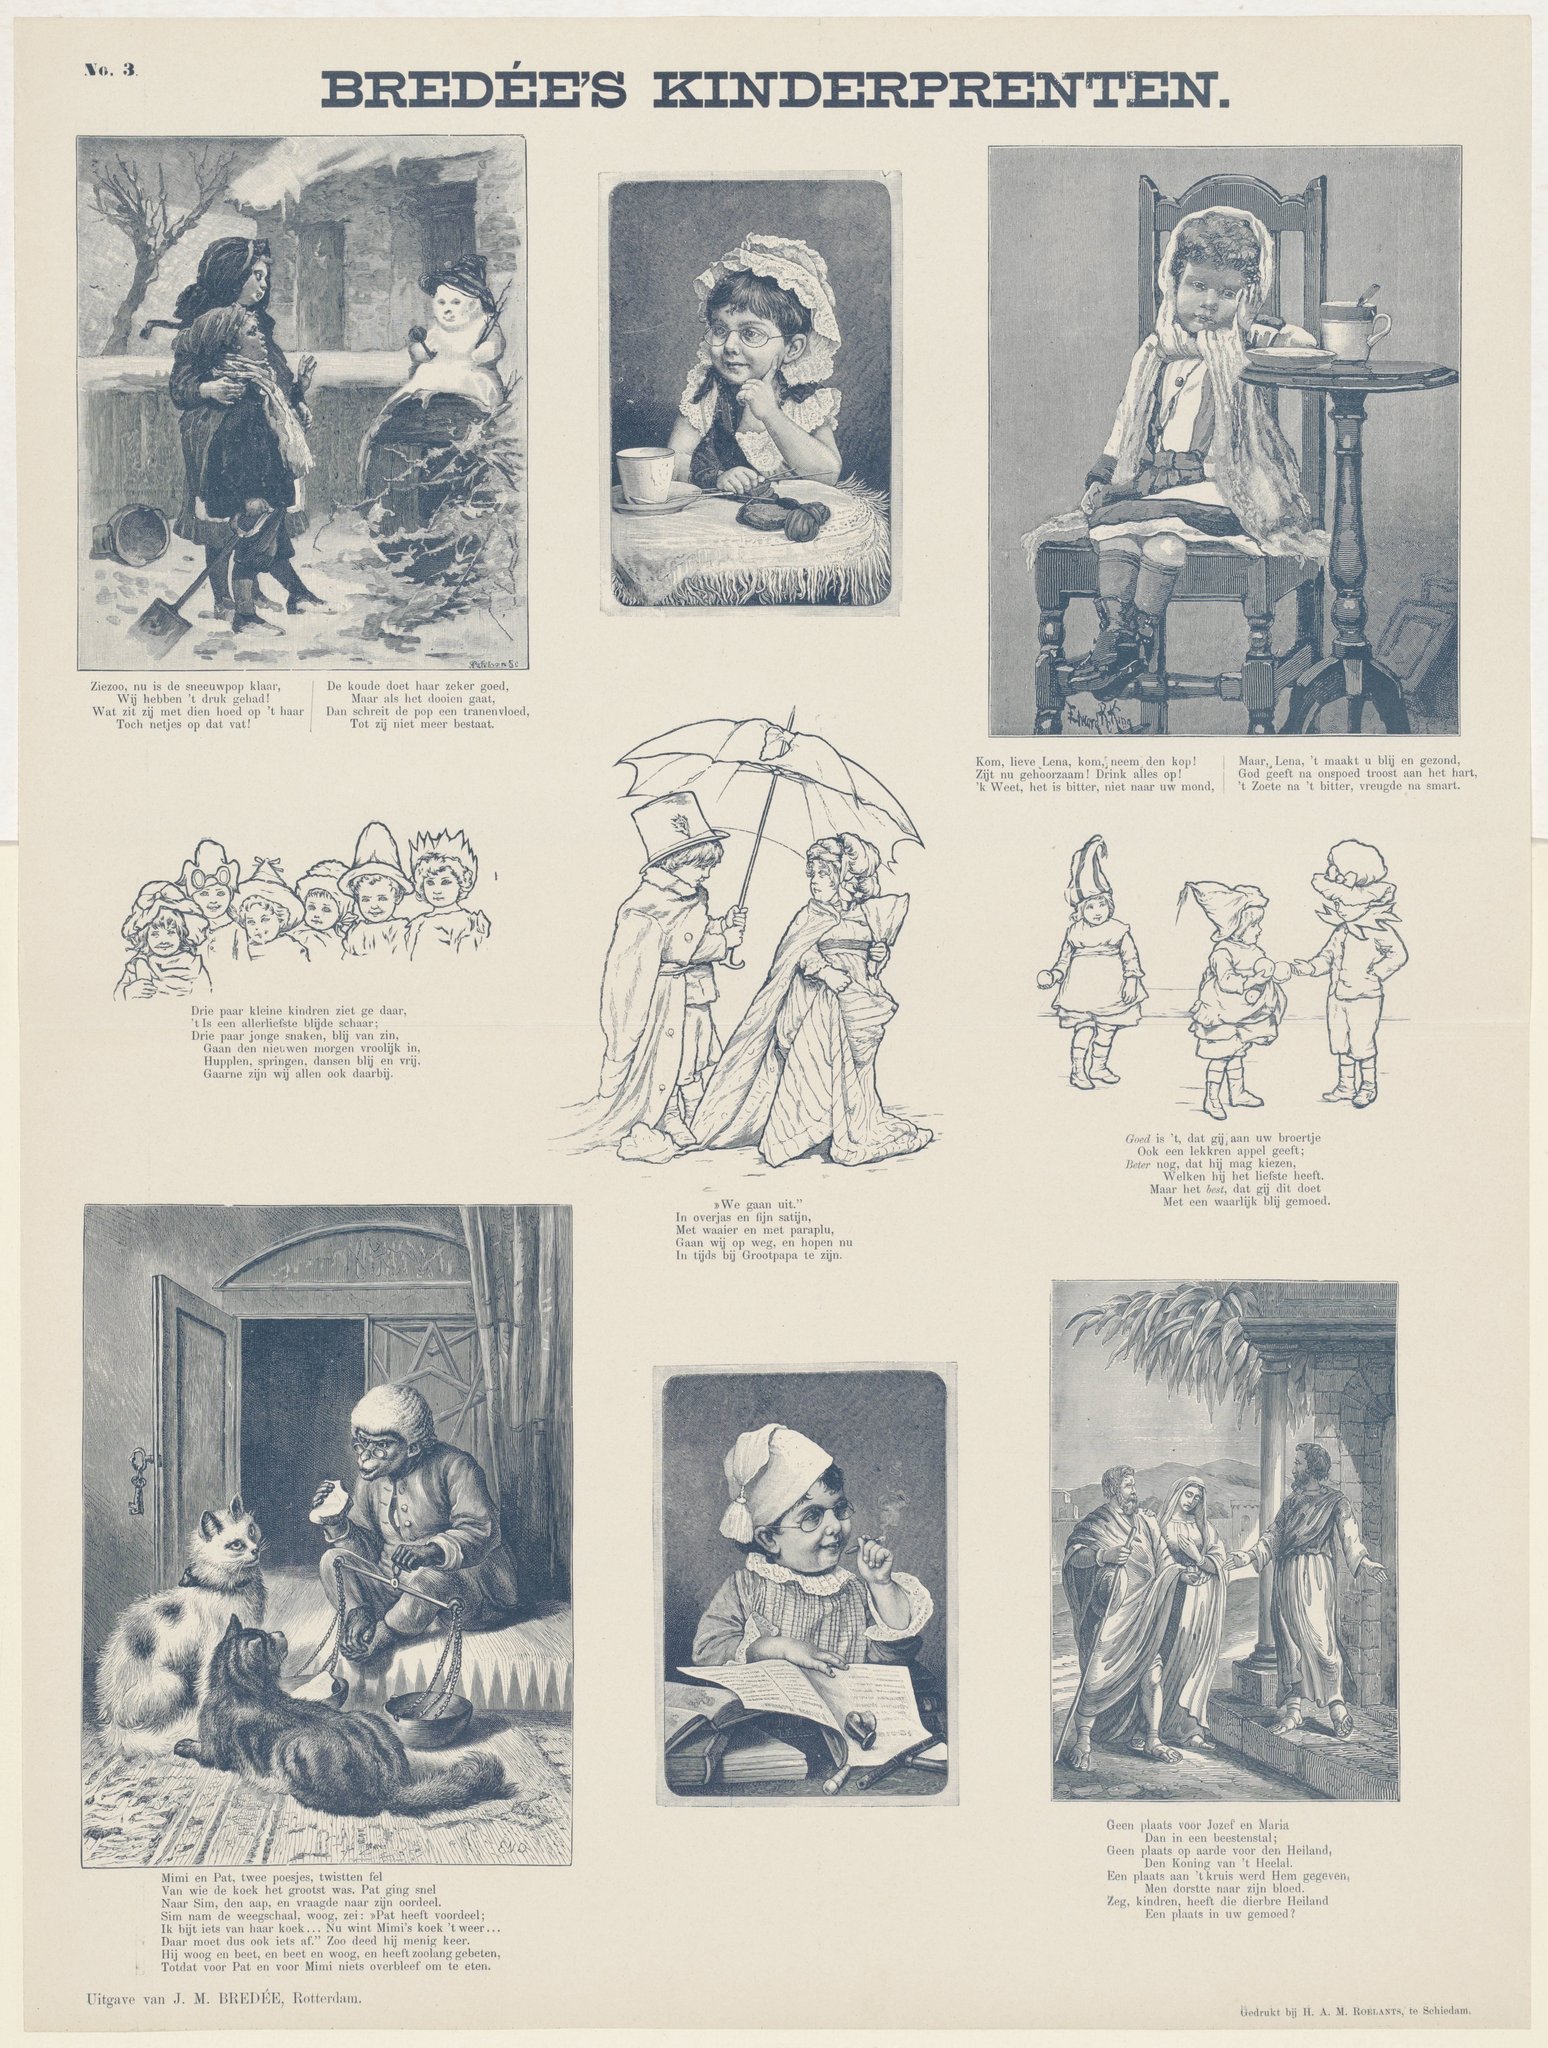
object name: print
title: Verschillende voorstellingen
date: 1894-1918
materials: paper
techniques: letterpress printing, line block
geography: schiedam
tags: smoke, (making a) snowman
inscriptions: collector's mark: Lugt 2760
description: Blad met 9 voorstellingen van verschillende aard, waaronder twee kinderen die een sneeuwpop bouwen en een kleuter die rookt. Onder elke afbeelding vier tot acht regels vers. Genummerd linksboven: No. 3.